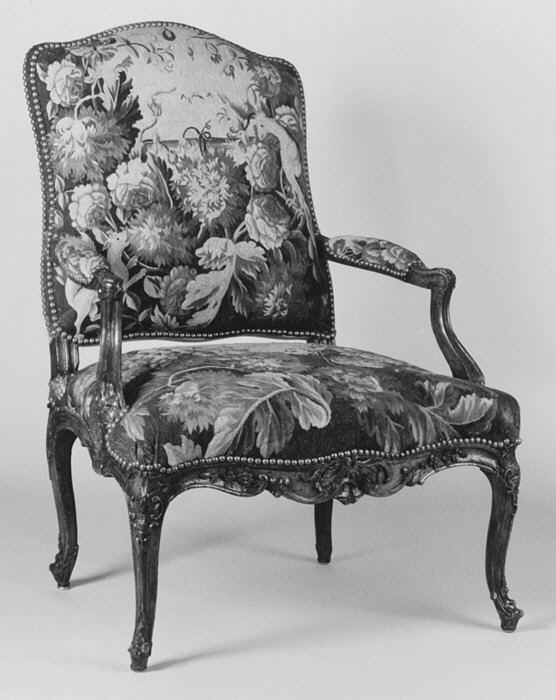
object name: armchair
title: Armchair (one of a set of four)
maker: aubusson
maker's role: factory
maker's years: 1665-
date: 1701-1800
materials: wood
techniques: carving, tapestry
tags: flowers